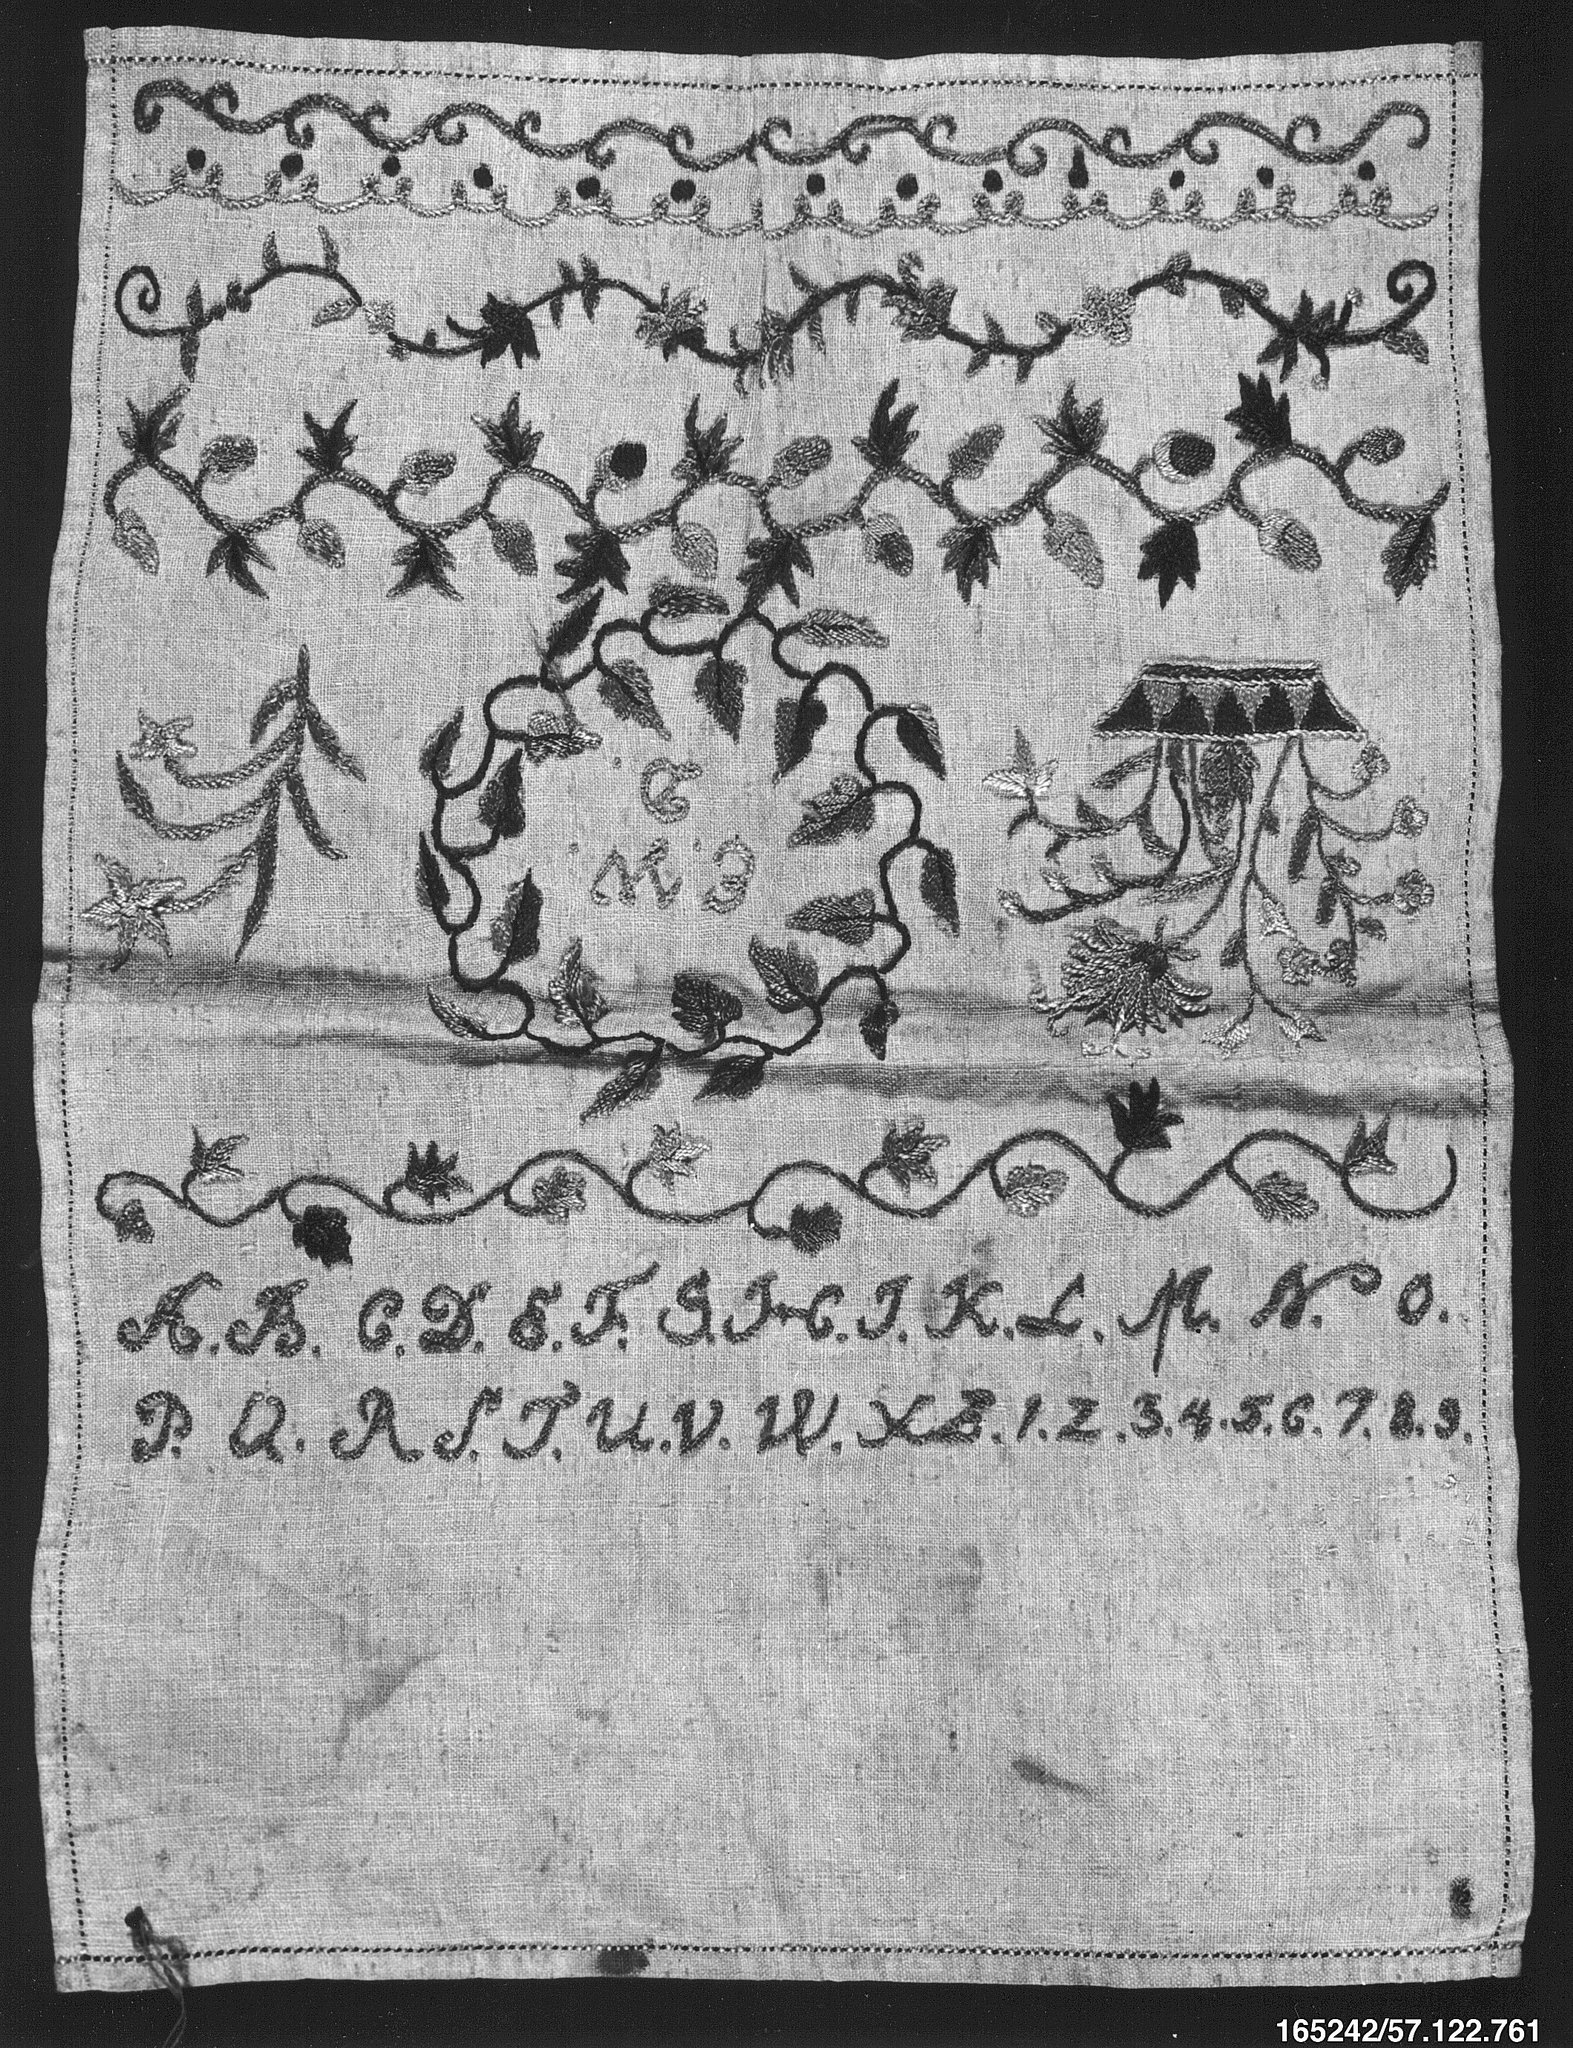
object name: sampler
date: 1801-1900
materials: linen, silk